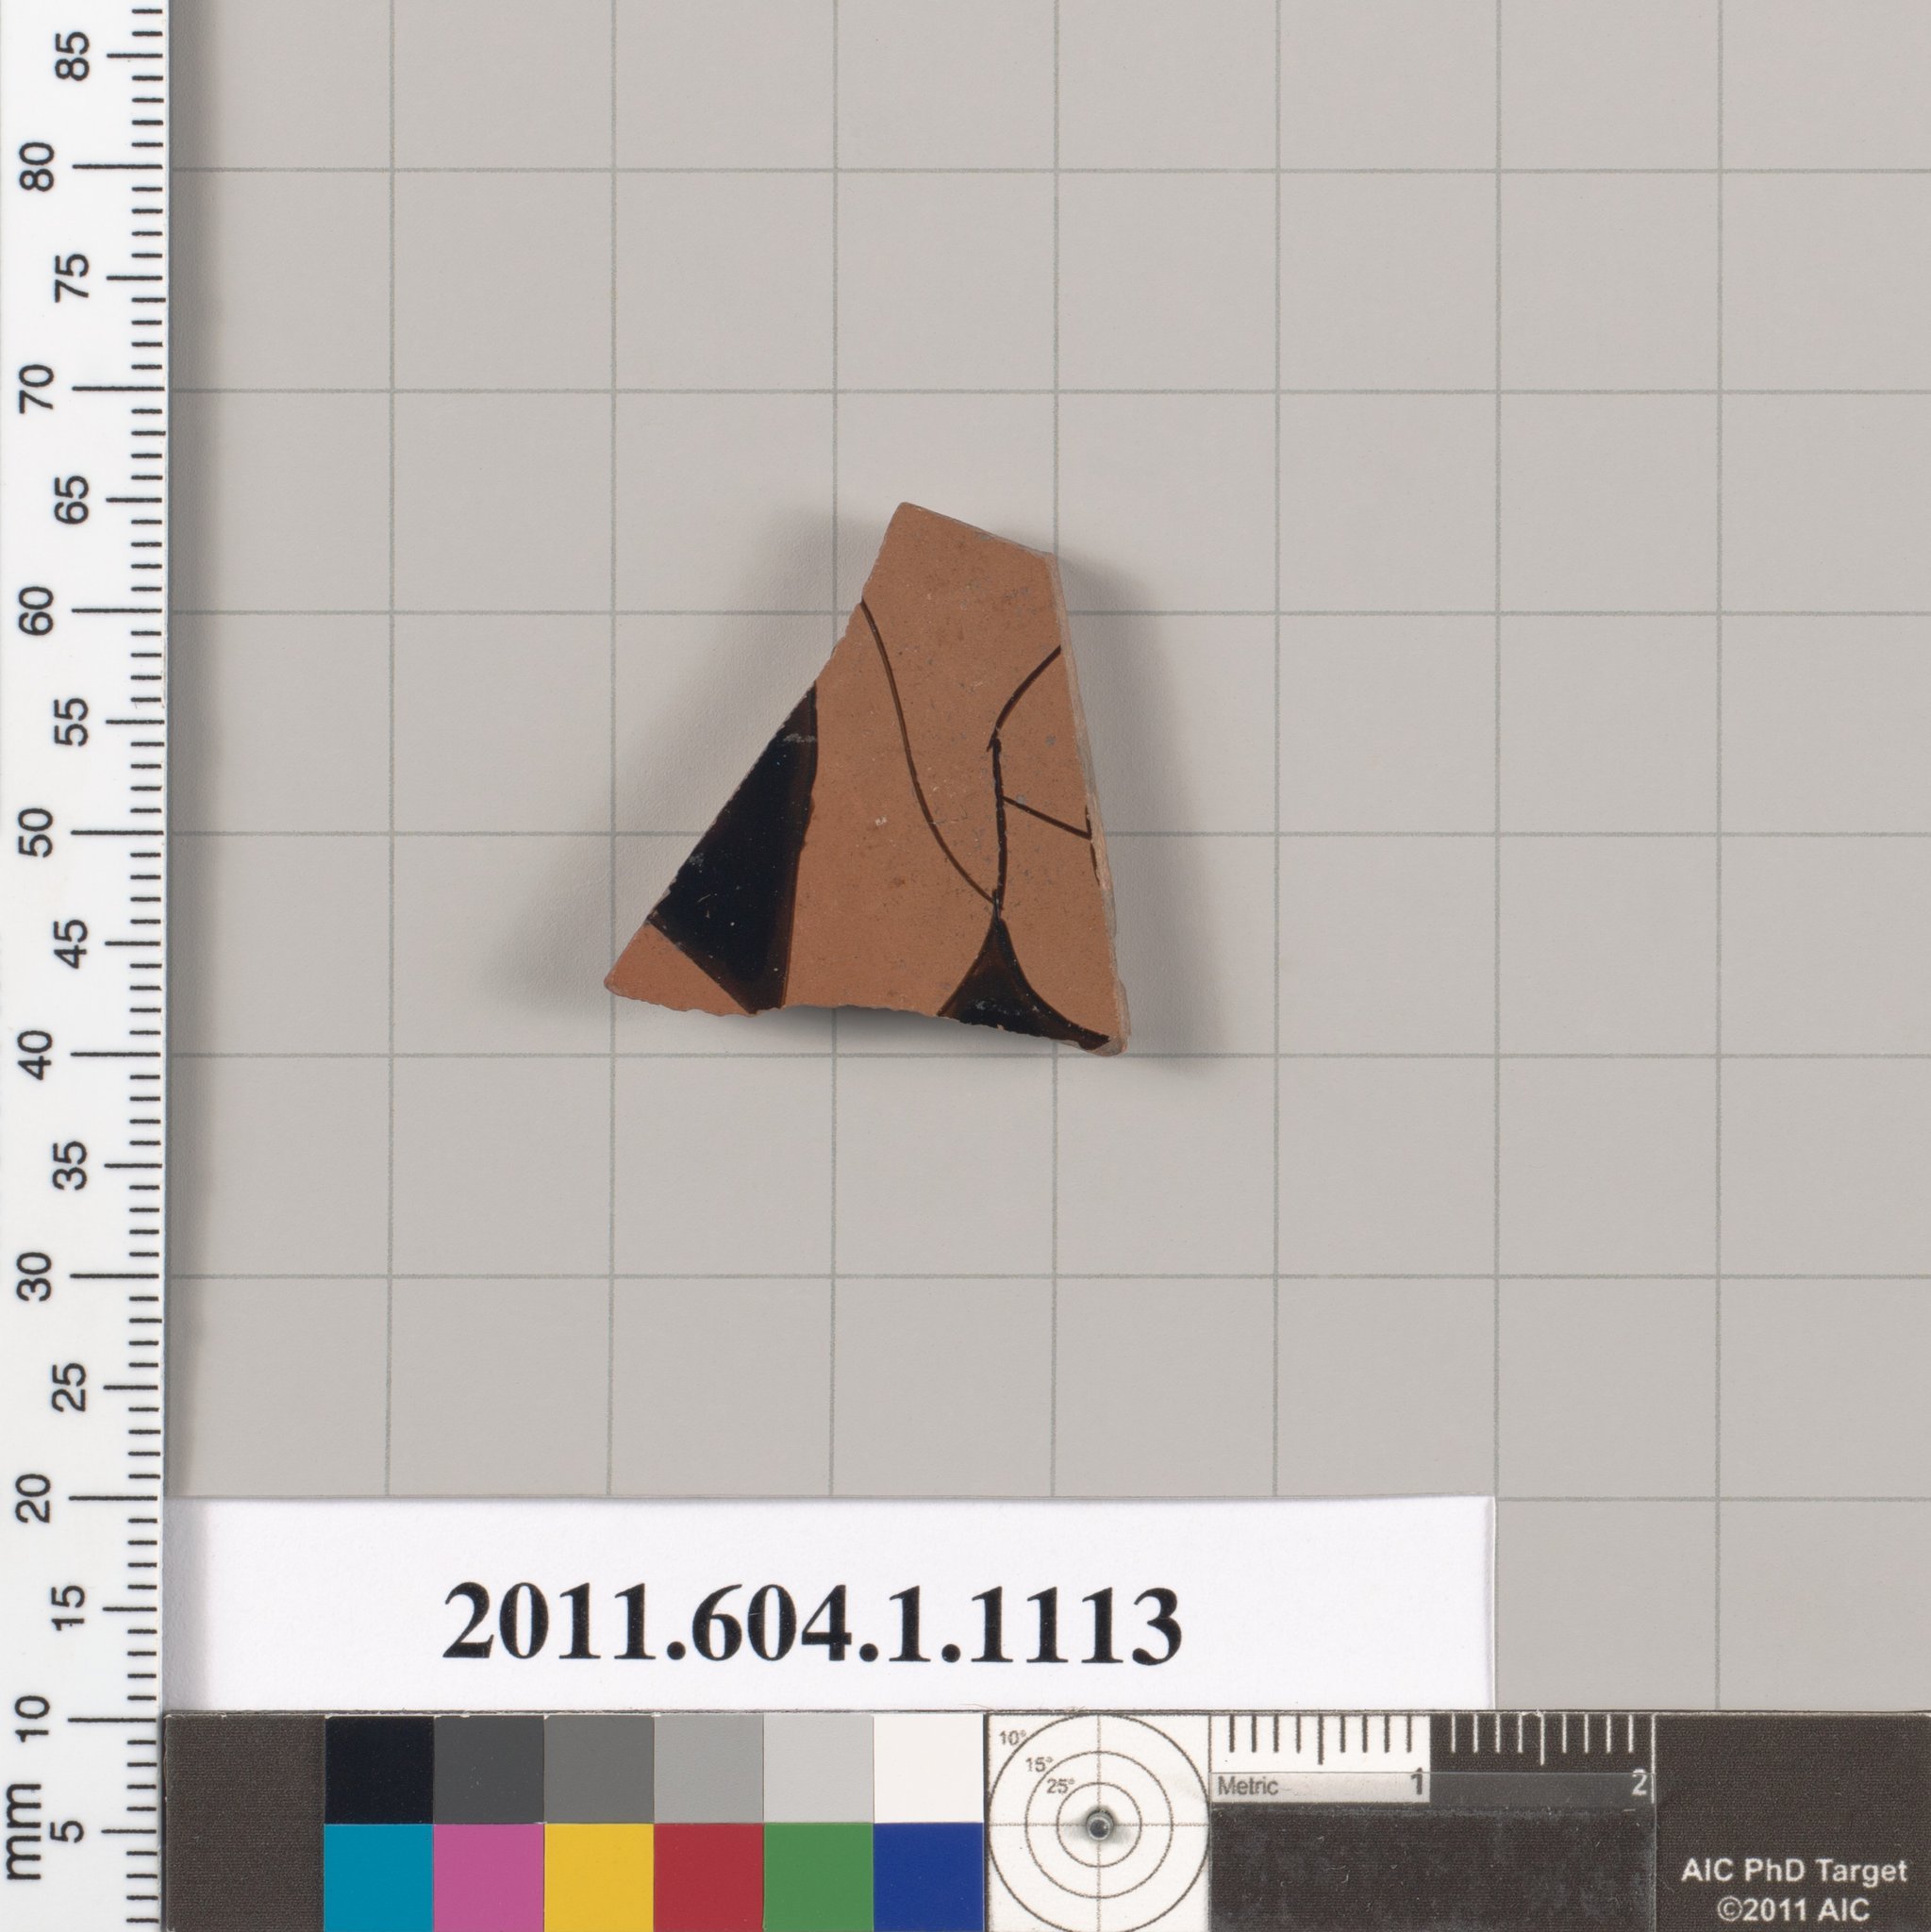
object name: kylix fragment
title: Terracotta fragment of a kylix (drinking cup)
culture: greek, attic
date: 490-480 BCE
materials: terracotta